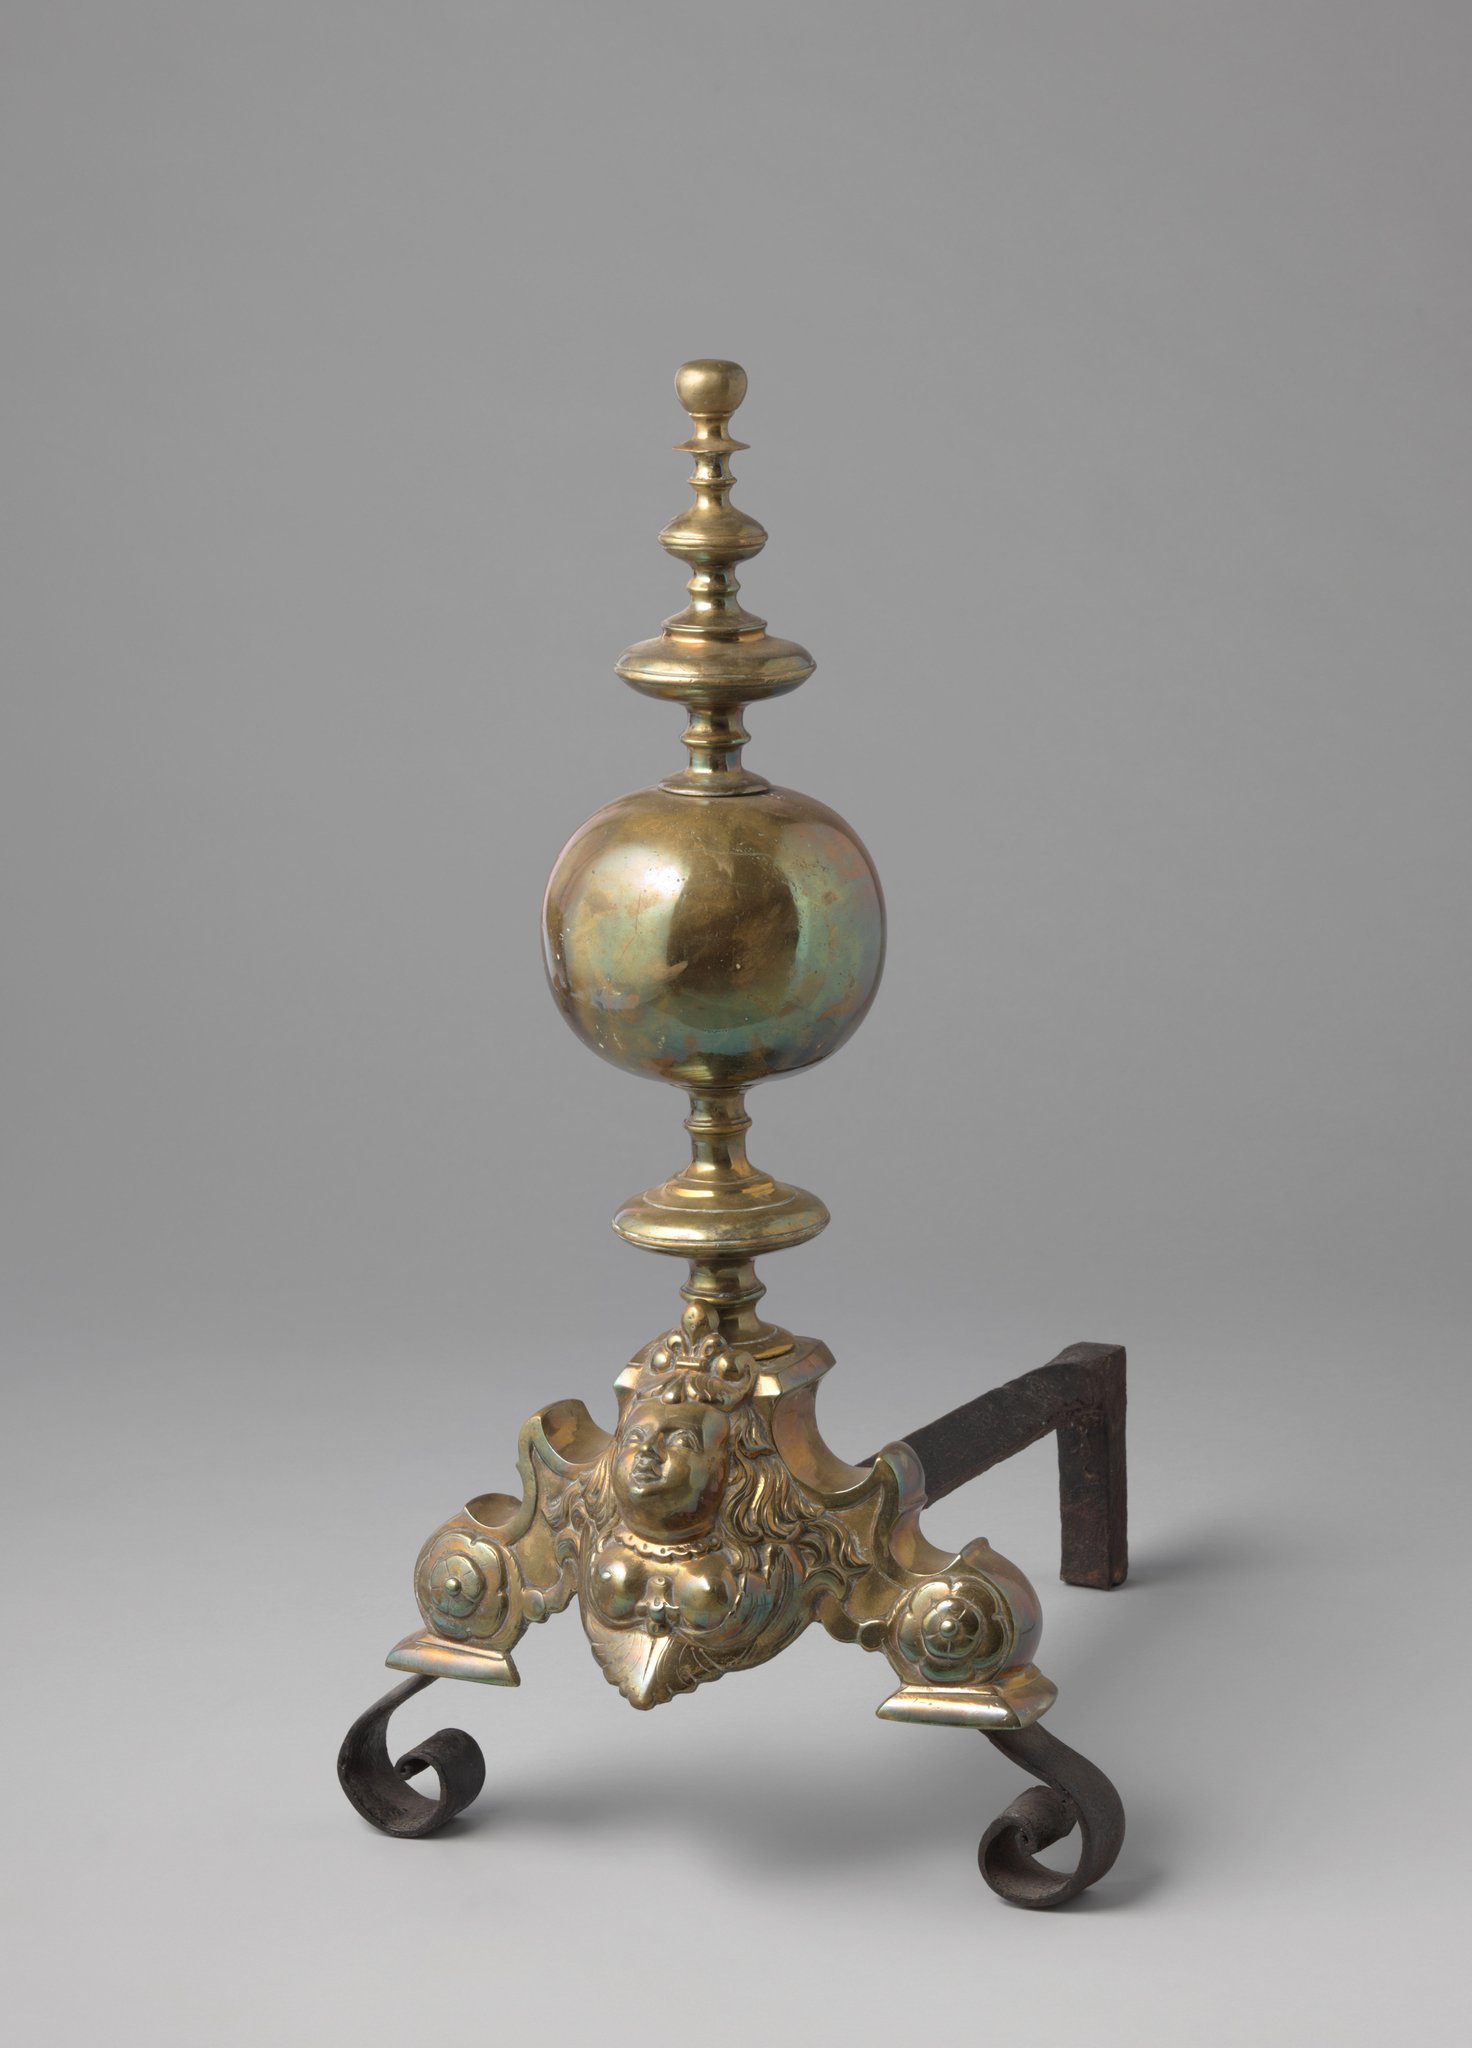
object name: andiron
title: Haardijzer met een versiering bestaande uit het borstbeeld van een vrouw en een bol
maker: Anonymous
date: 1625-1650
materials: brass, iron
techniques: casting, metalworking, engraving, forging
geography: southern netherlands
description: Het voorwerp bestaat uit drie met moeren vastgeschroefde smeedijzeren delen: de stang, waaro het hout gelegd kan worden, de in twee krullen eindigende voet, de verticale aan de einden van schroefdraden voorziene stang ter bevestiging van de versiering. Deze bestaat uit vier gegoten, geciseleerde en gegraveerde geelkoperen delen: de basis, de stam, de bol, de knop. De basis, waarvan het profiel scherp in- en uitzwenkt, heeft twee met rozetten versierde voeten enis in het midden gedecoreerd met het borstbeeld van een vrouw. De geprofileerde stam heeft een nodus. De bol is glad. De rijk geprofileerde knop heeft drie knopen. De knop is aan de binnenkant met ijzer volgegoten. Daarin is een van een schroefdraad voorzien gat aangebracht zodat hij op de stang kan worden vastgedraaid.